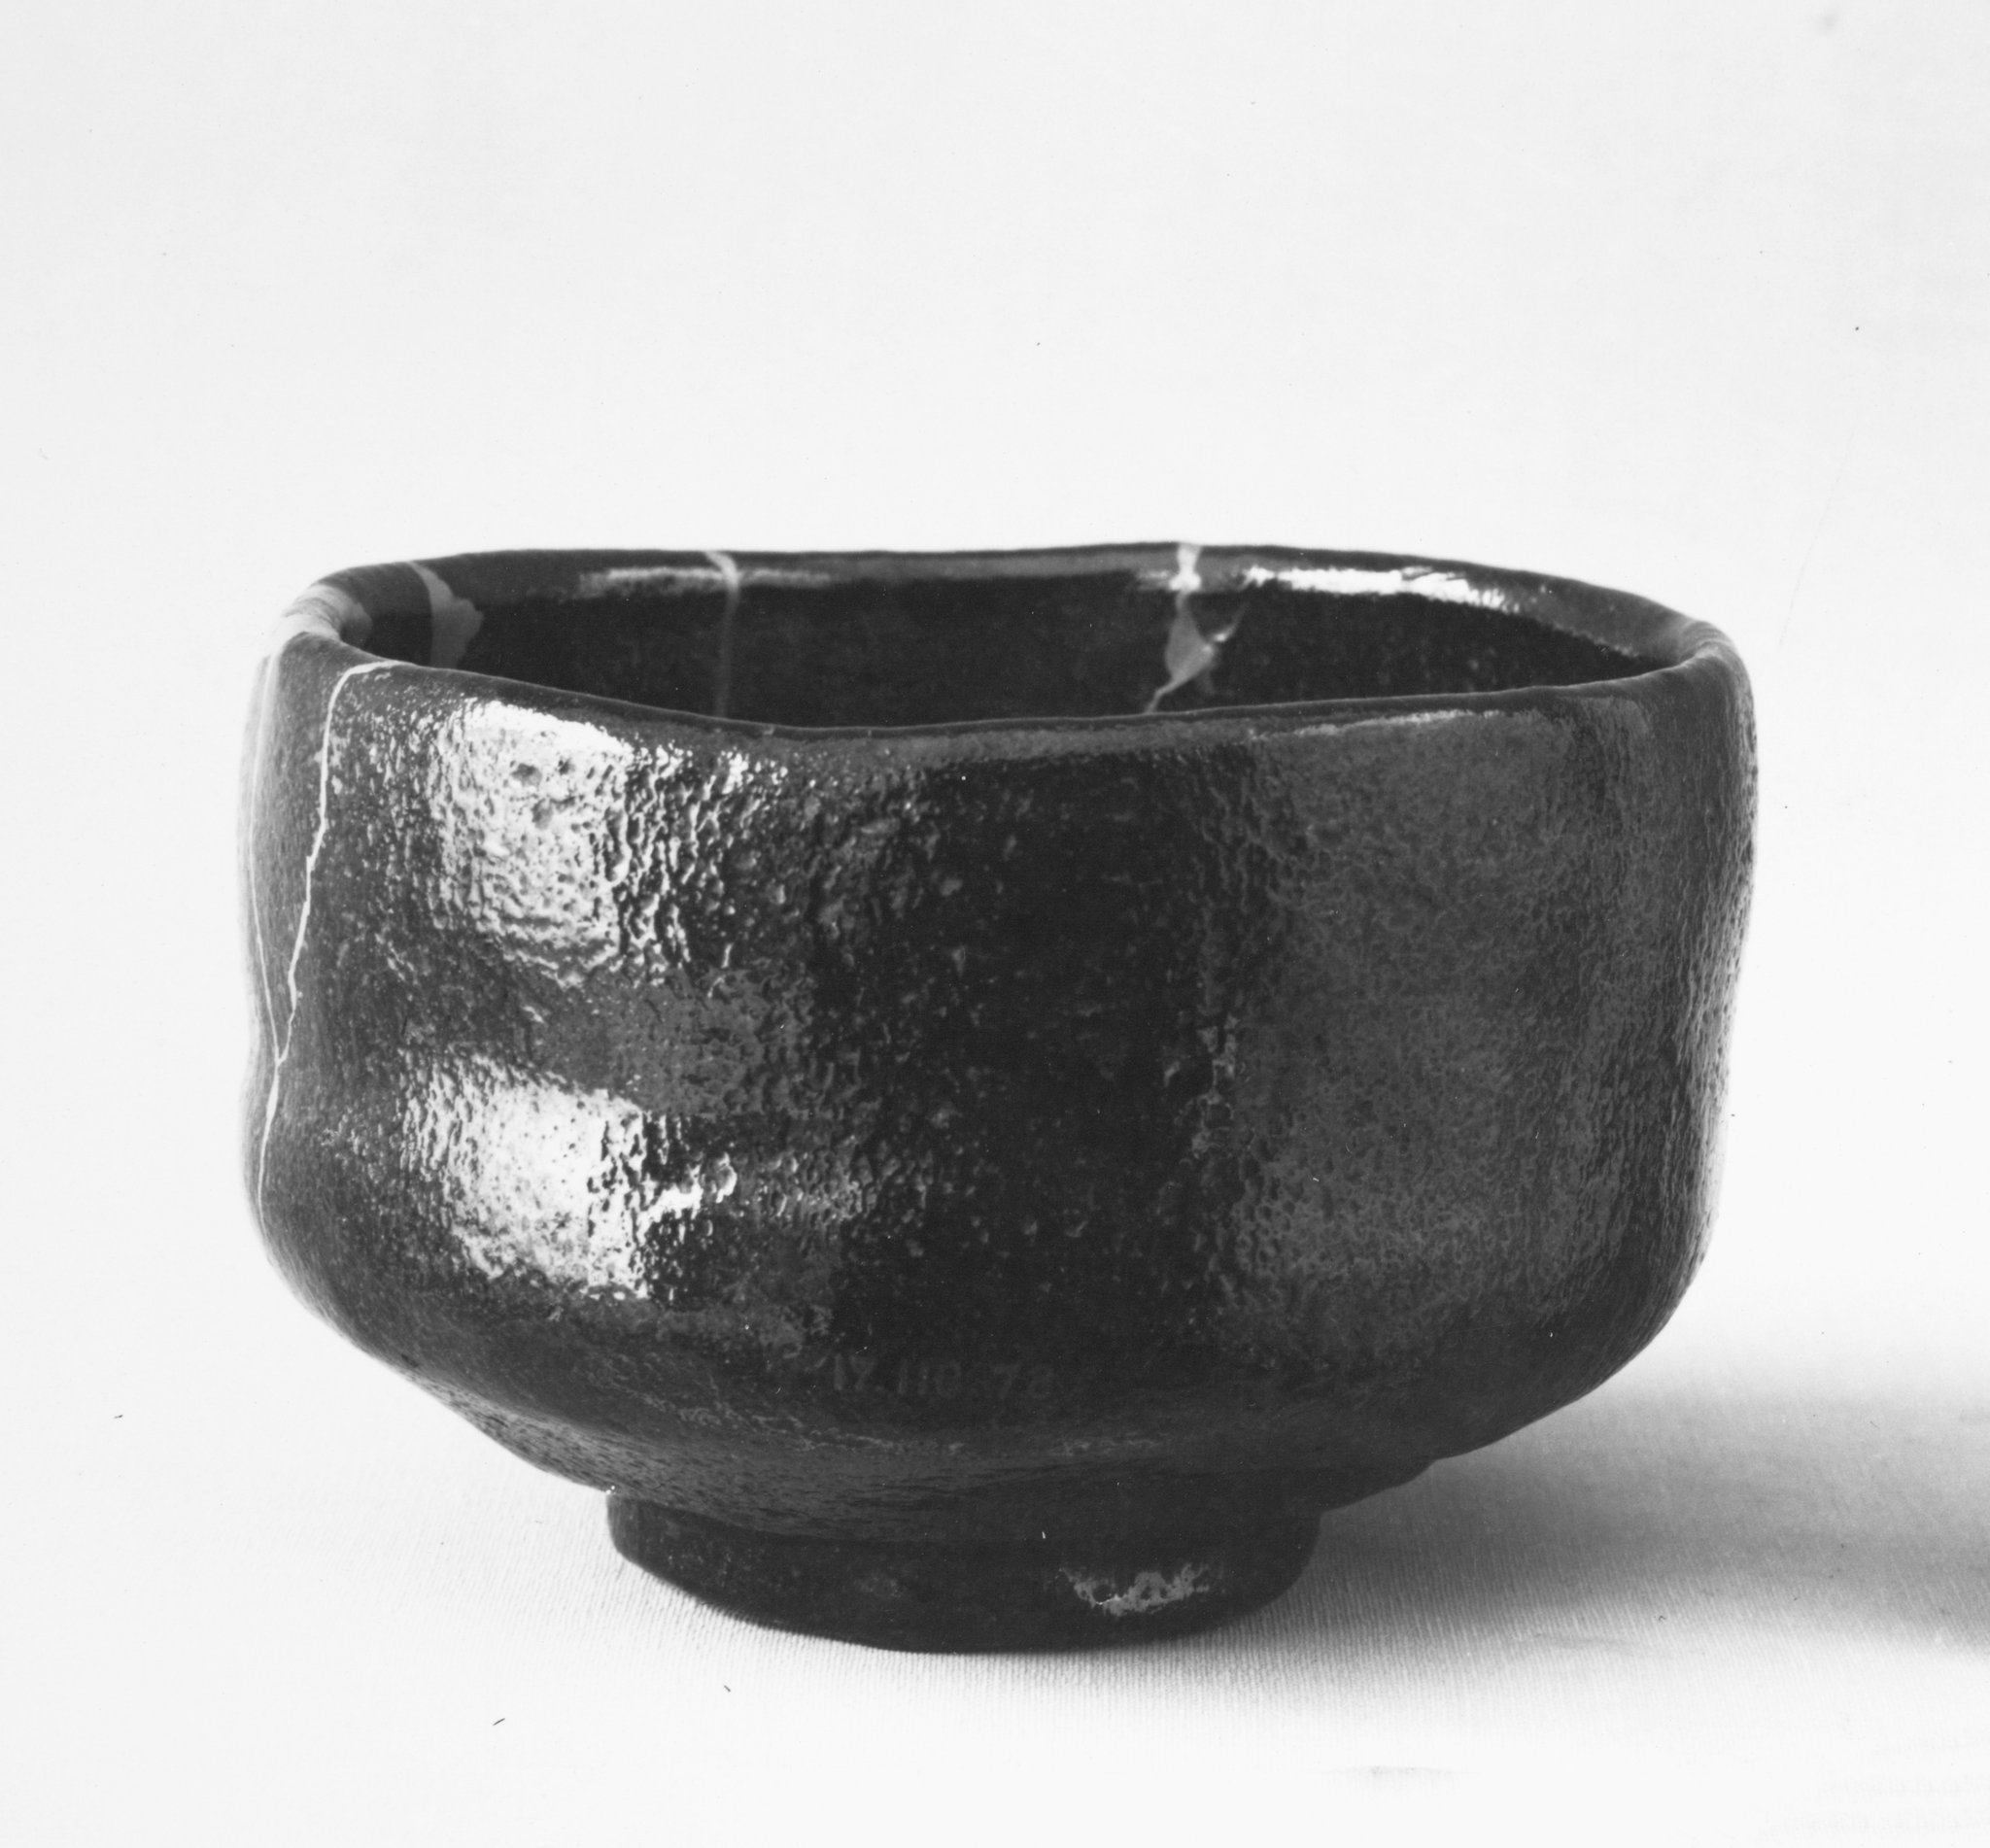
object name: teabowl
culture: japanese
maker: ichinyu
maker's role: artist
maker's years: 1582-1682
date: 1675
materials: clay, glaze